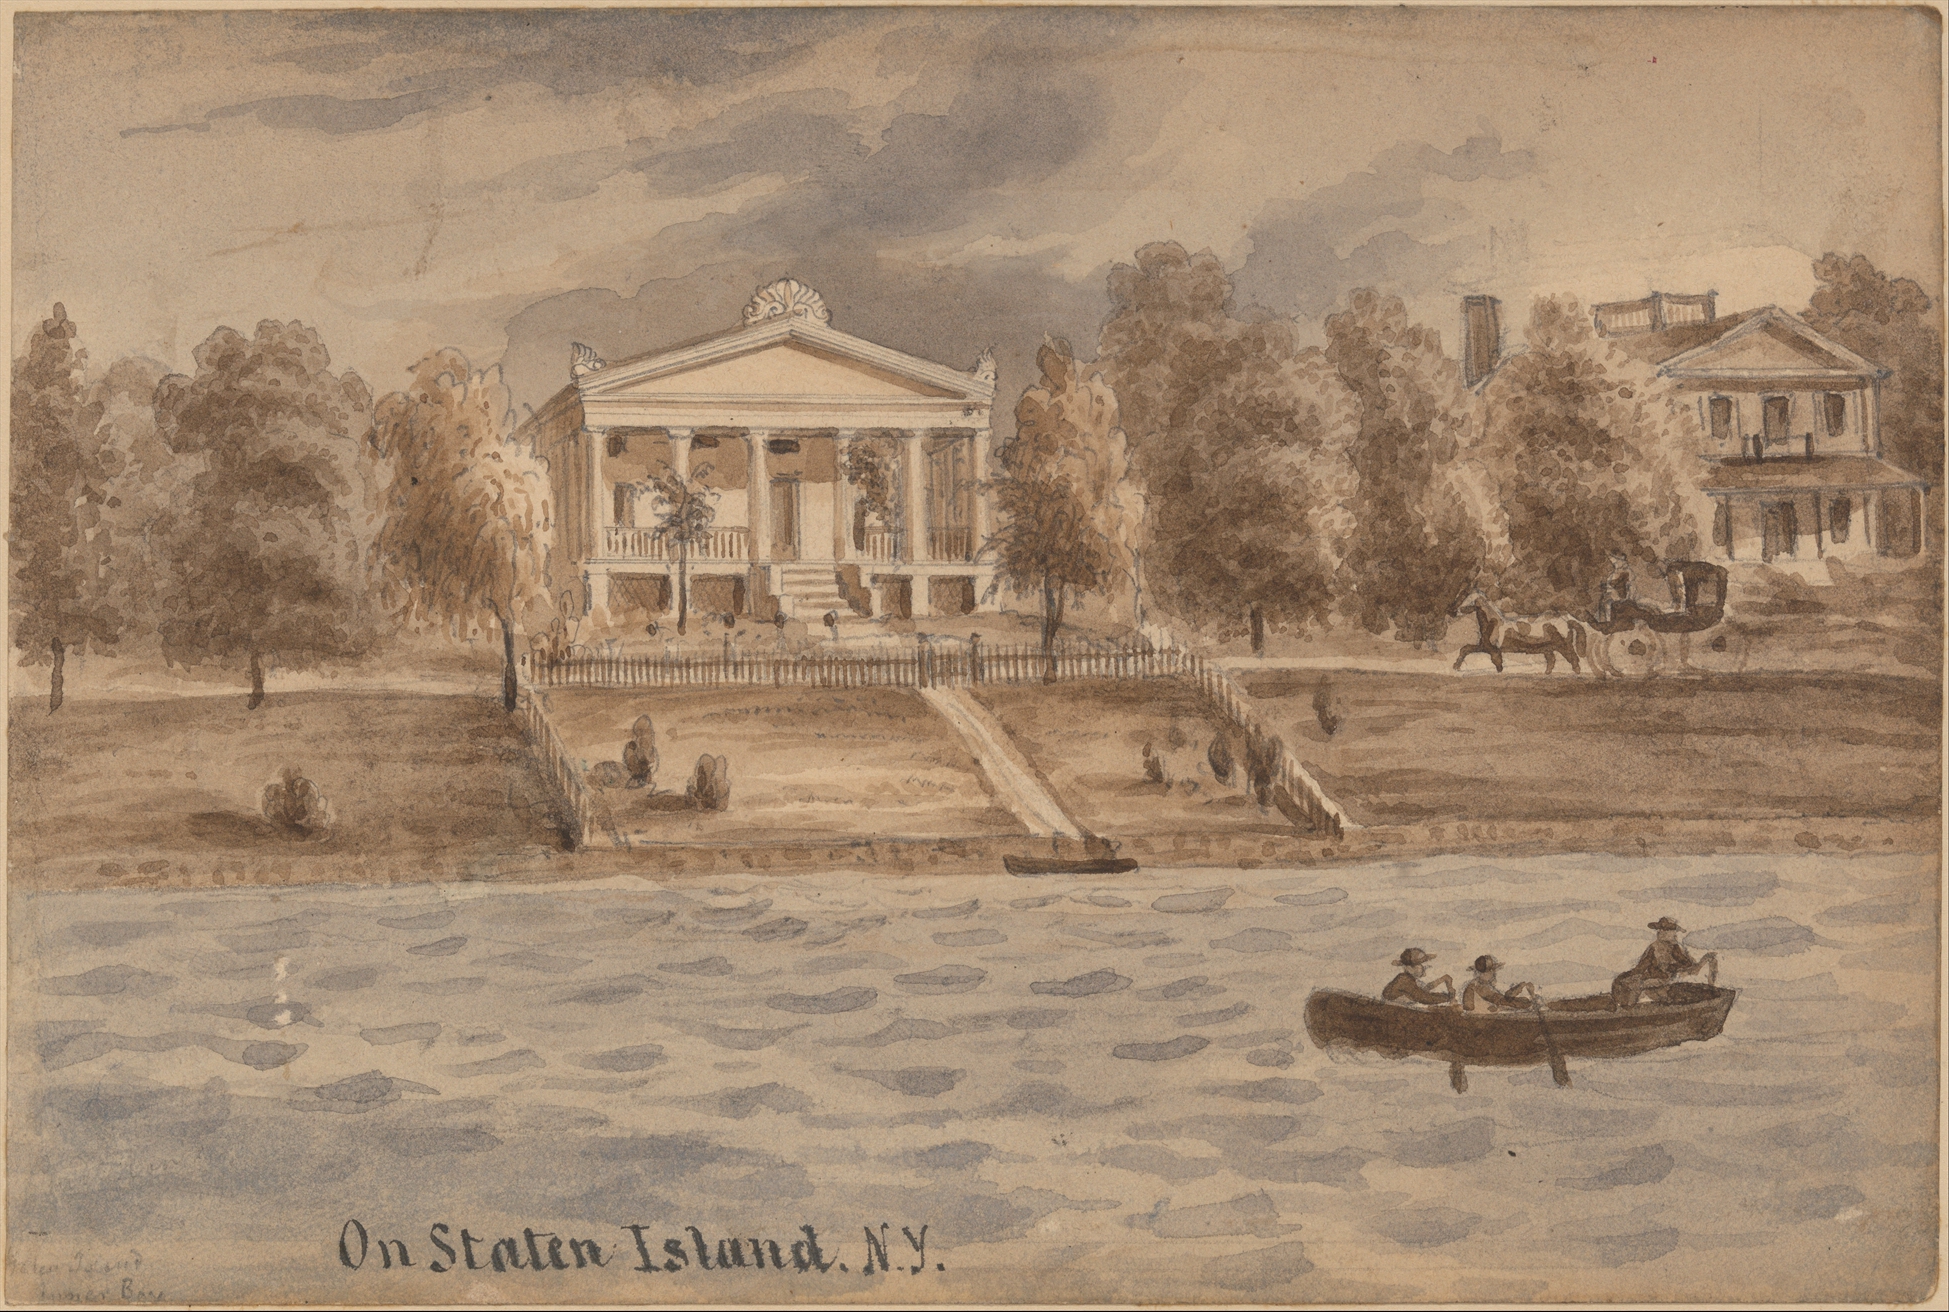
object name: drawing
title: Inner Bay, Staten Island, New York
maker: augustus kollner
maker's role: artist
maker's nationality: american, born germany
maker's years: 1812-1906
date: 1872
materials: watercolor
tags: houses,boats,new york city